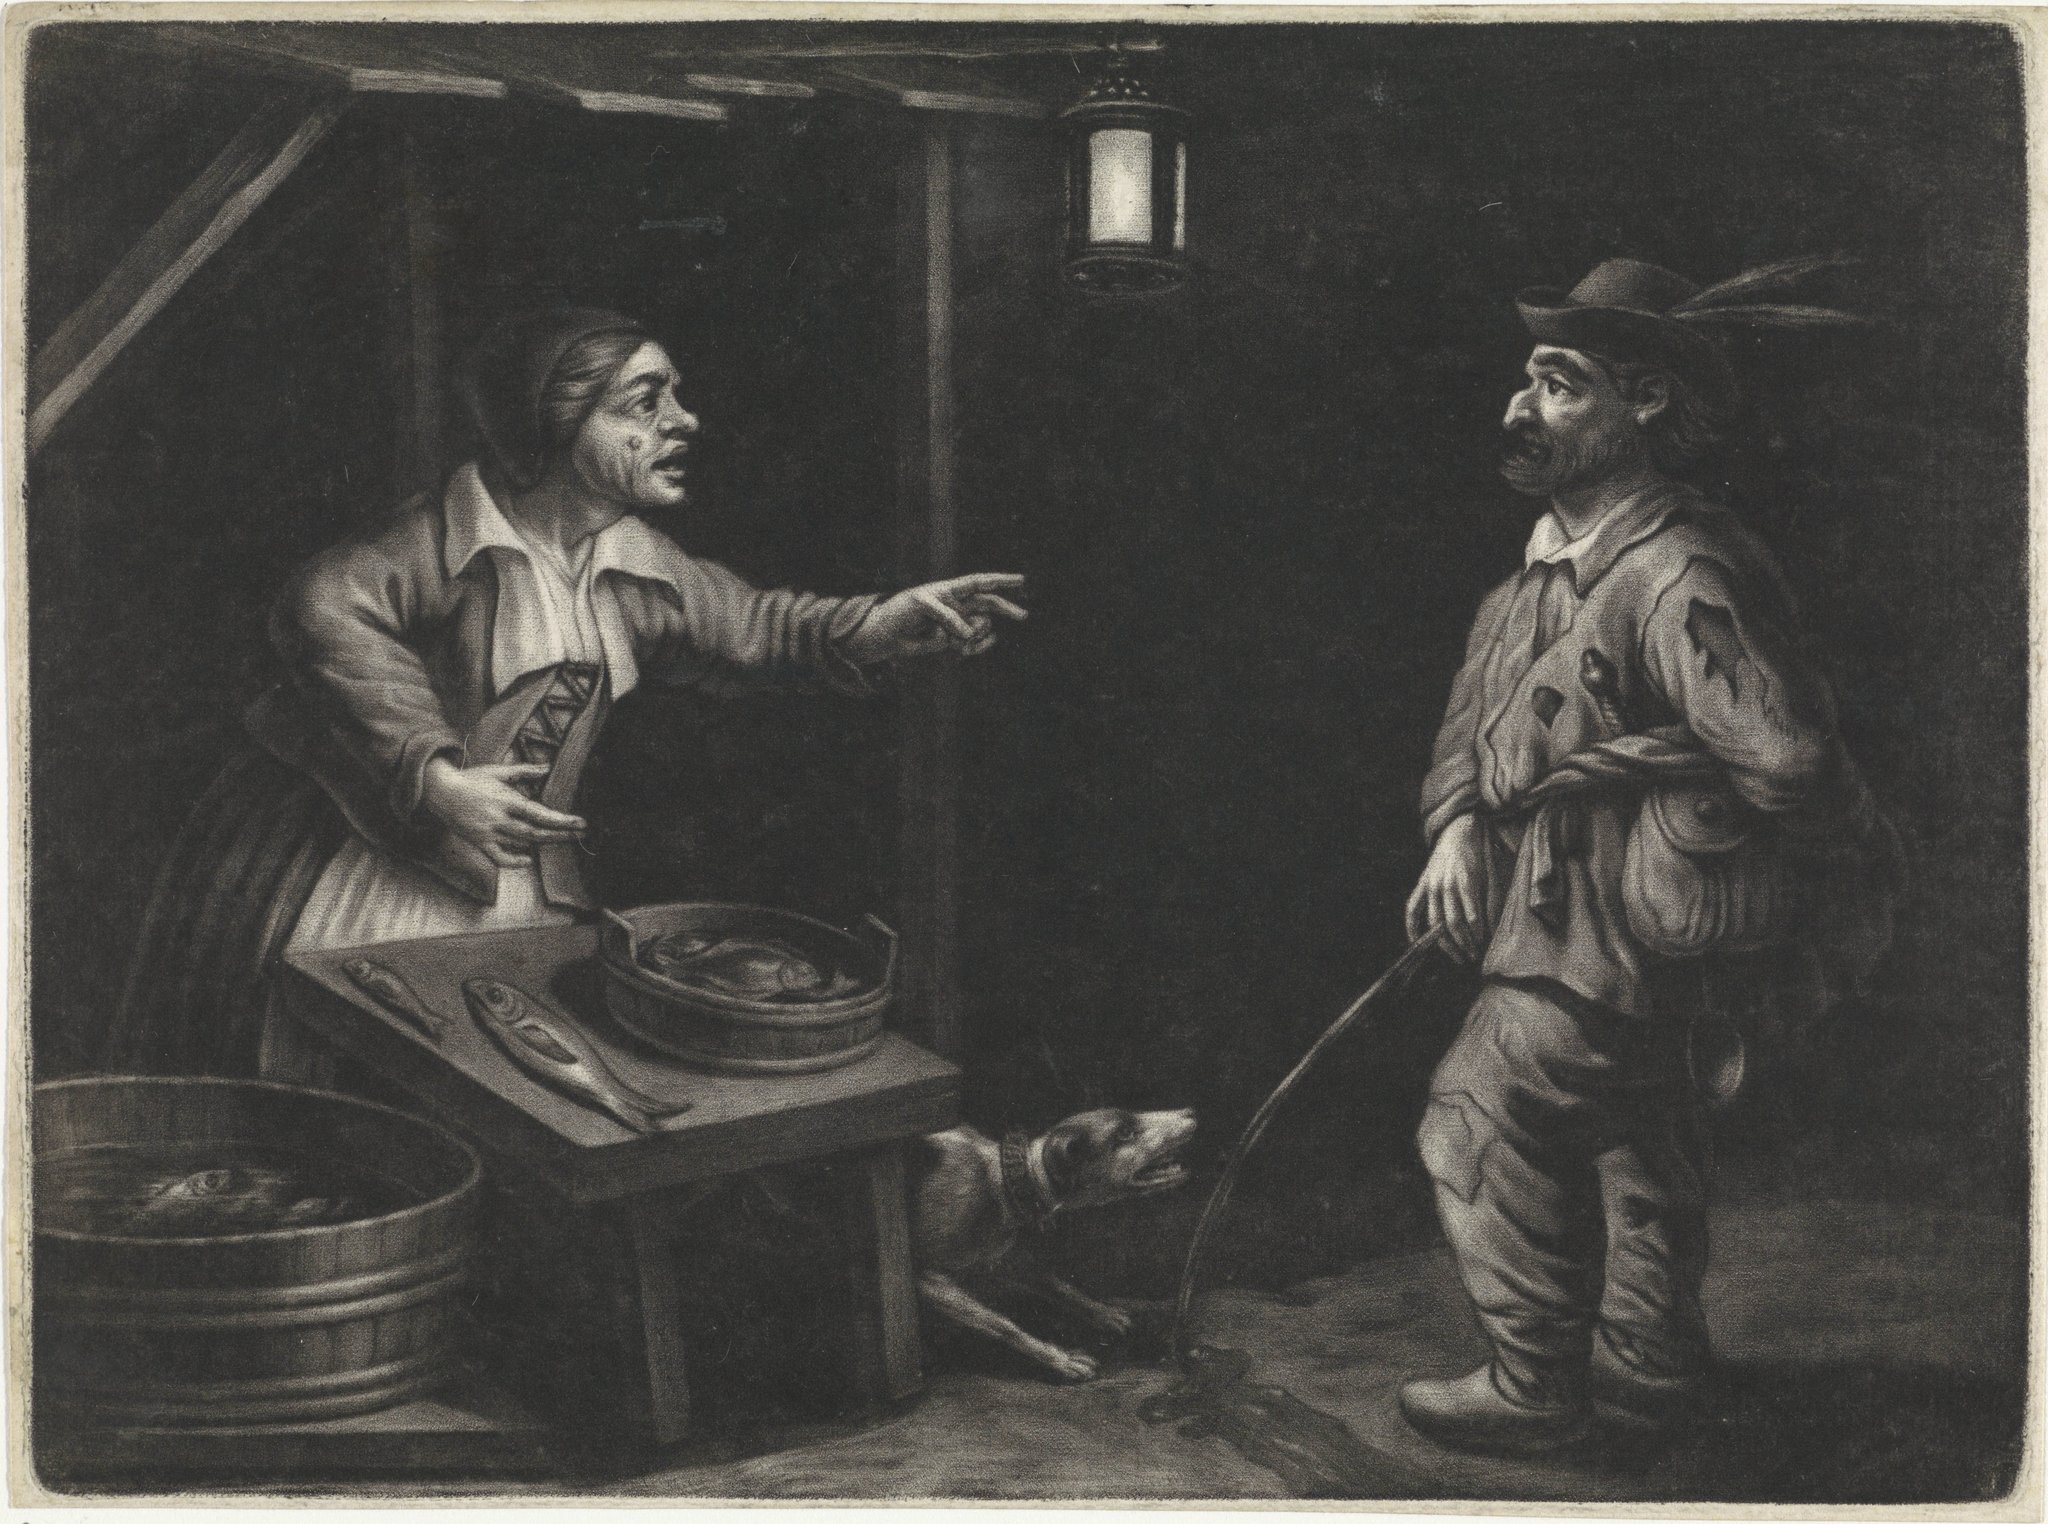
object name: print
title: Nachtgezicht met visverkoopster en een urinerende man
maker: jan van der bruggen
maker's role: draughtsman, print maker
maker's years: 1649-1709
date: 1659-1740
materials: paper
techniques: mezzotint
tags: fishes, stall, booth (~ market), merchant, salesman (with name of trade or profession) - bb - women engaged in trade and commerce, urination, dog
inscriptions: collector's mark: Lugt 2228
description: Nachtgezicht. Onder een door een lantaarn verlichte luifel staat een visverkoopster. Zij spreekt een landloper aan die voor haar kraam staat te plassen. Haar hond blaft naar de man.